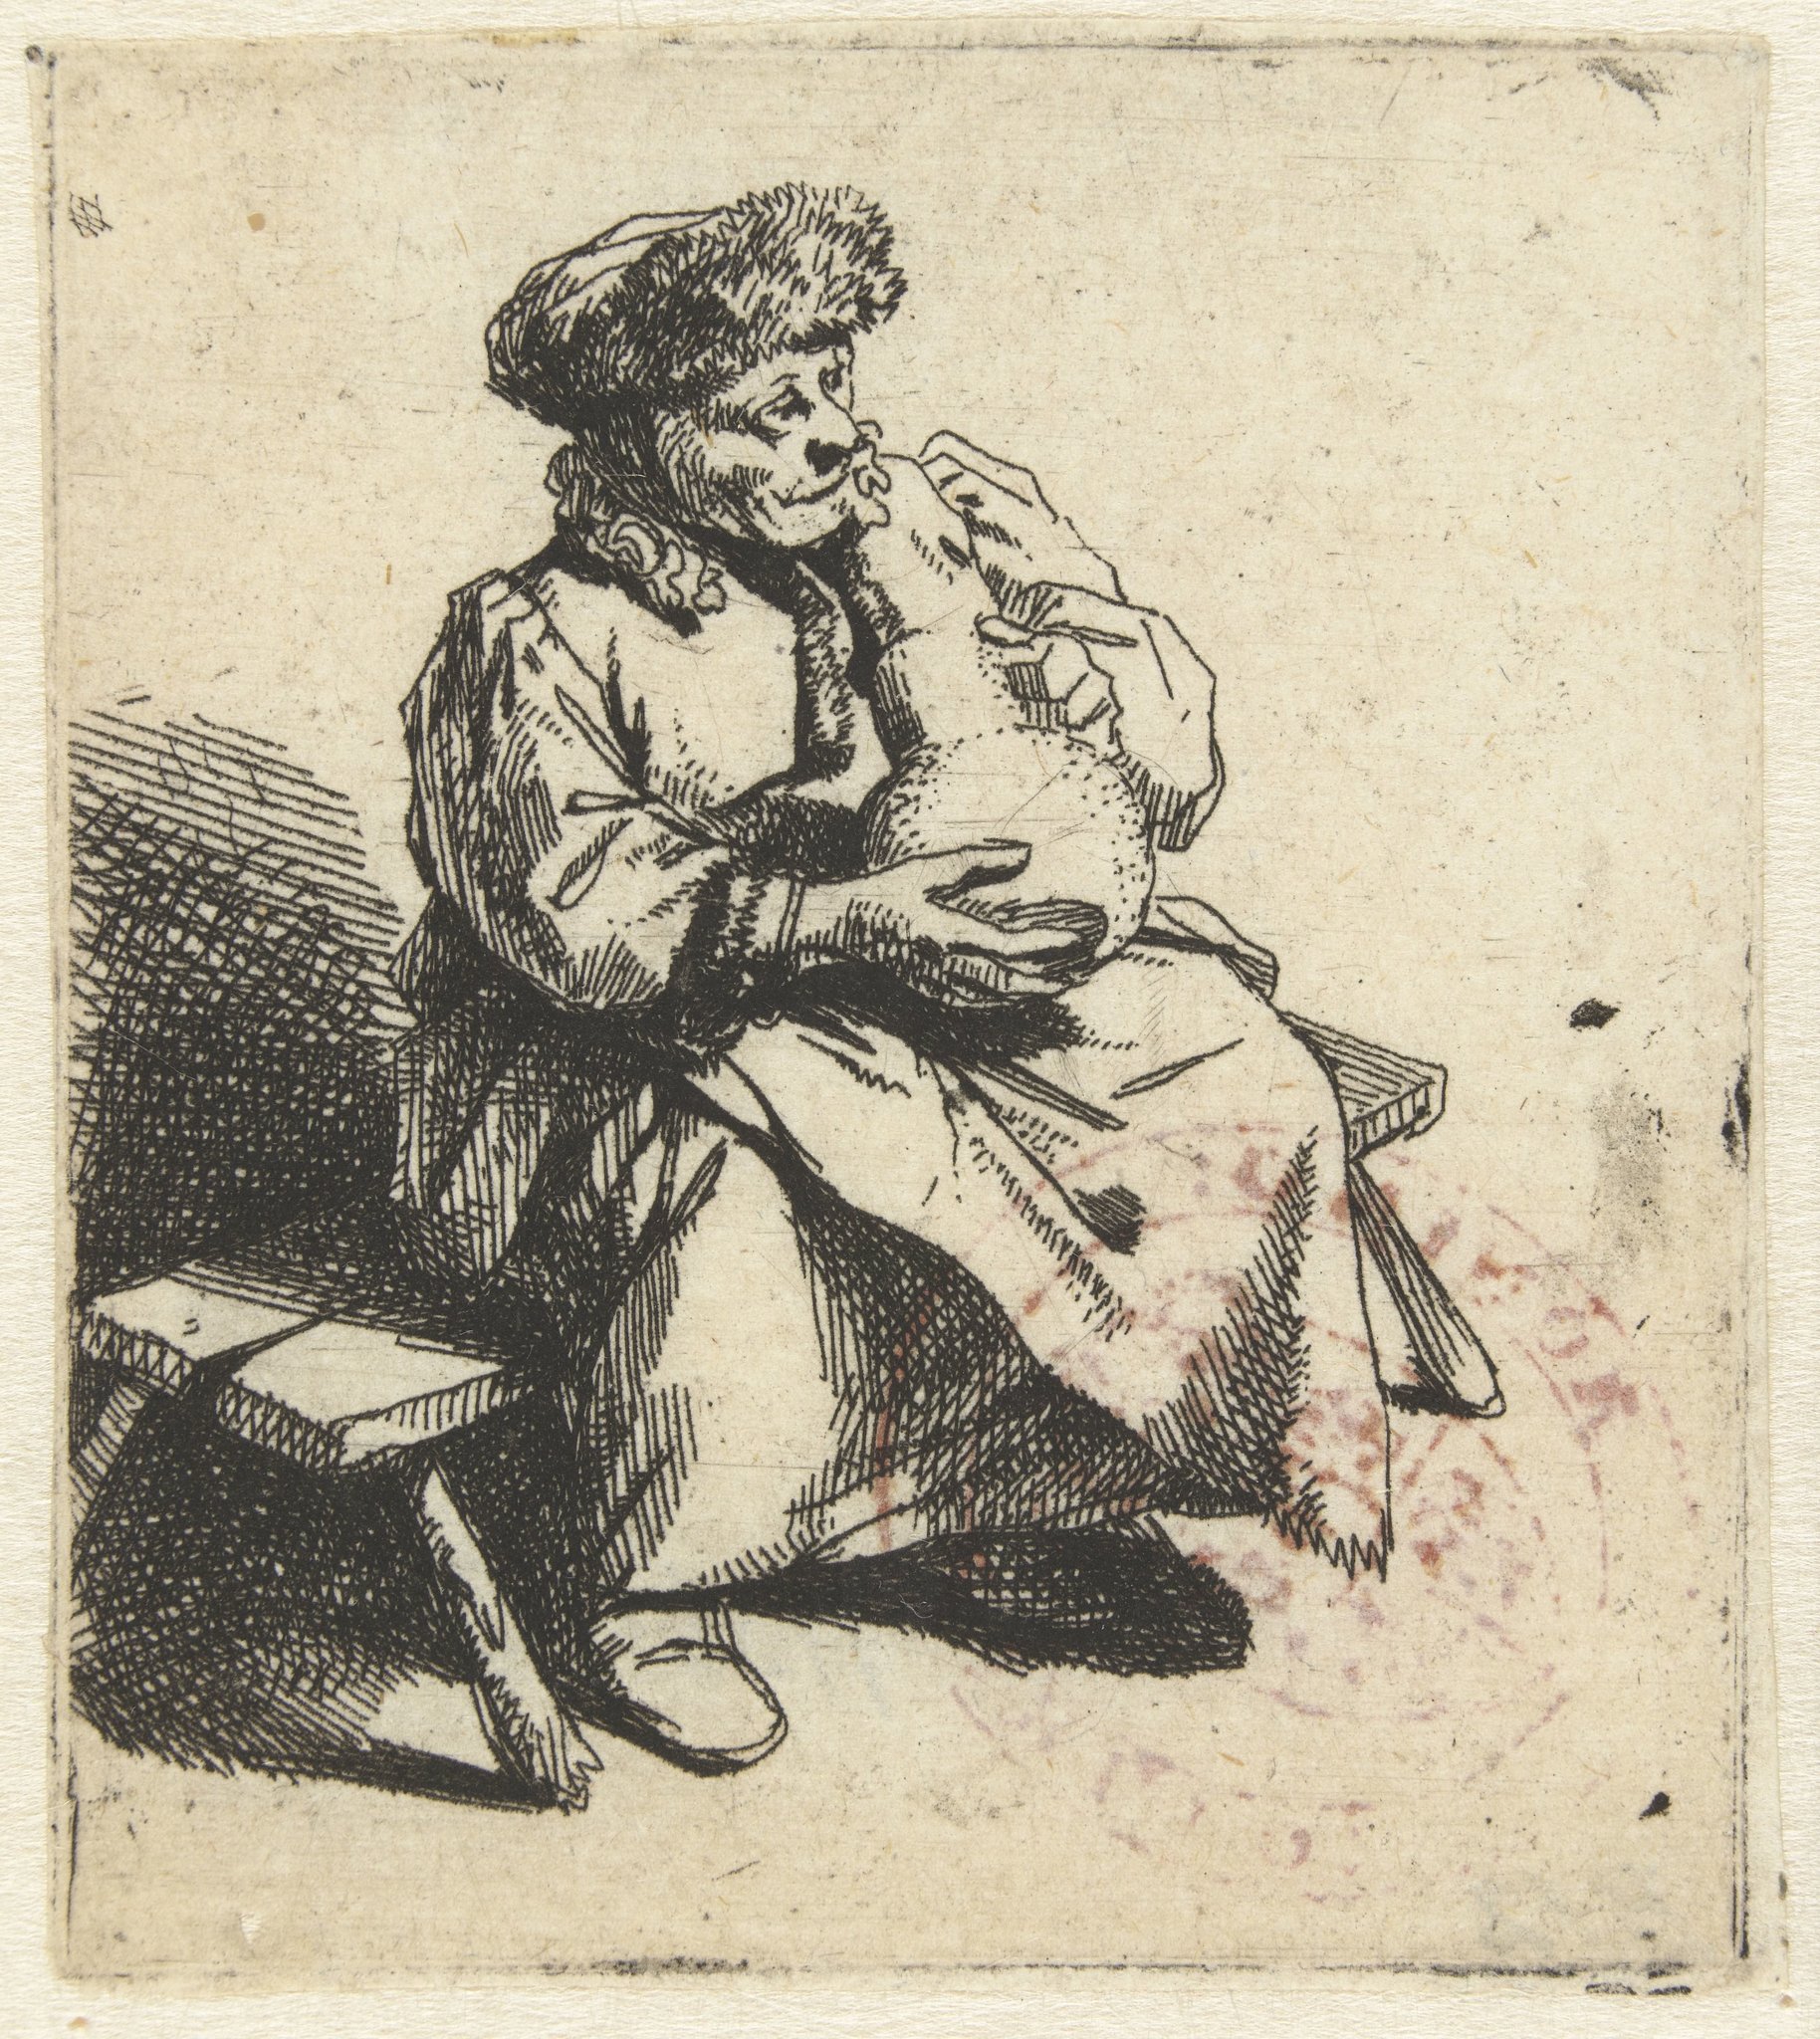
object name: print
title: Vrouw zittend met een kruik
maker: cornelis pietersz. bega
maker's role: draughtsman, painter, print maker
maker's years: 1631-1664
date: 1642-1664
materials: paper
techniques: etching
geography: netherlands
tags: female sex; woman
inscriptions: collector's mark: Lugt 240